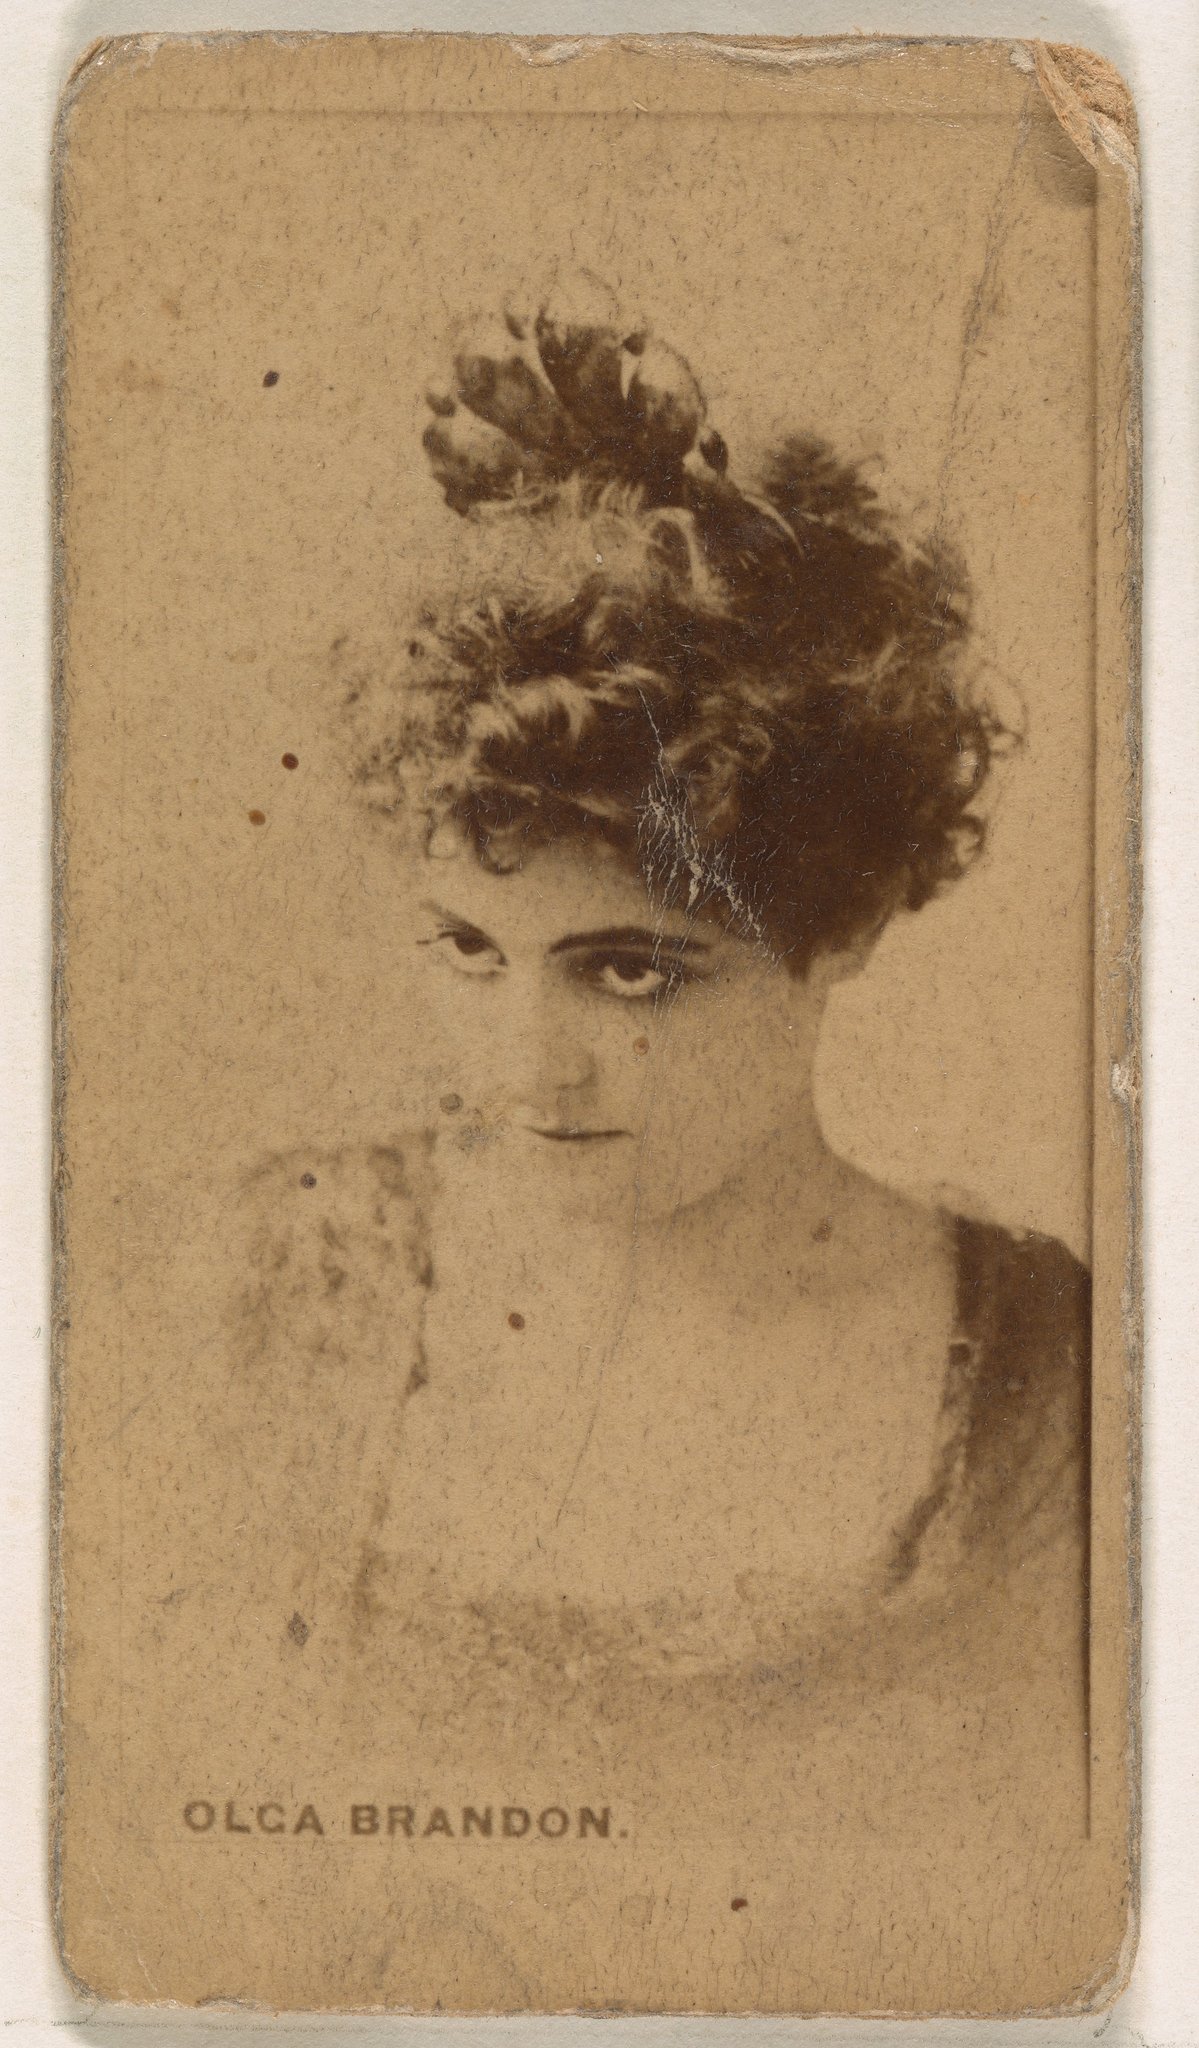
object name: photograph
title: Olga Brandon, from the Actresses series (N245) issued by Kinney Brothers to promote Sweet Caporal Cigarettes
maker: kinney brothers tobacco company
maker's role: publisher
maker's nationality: american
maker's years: 1869-2011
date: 1890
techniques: albumen silver print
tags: portraits,women,actresses